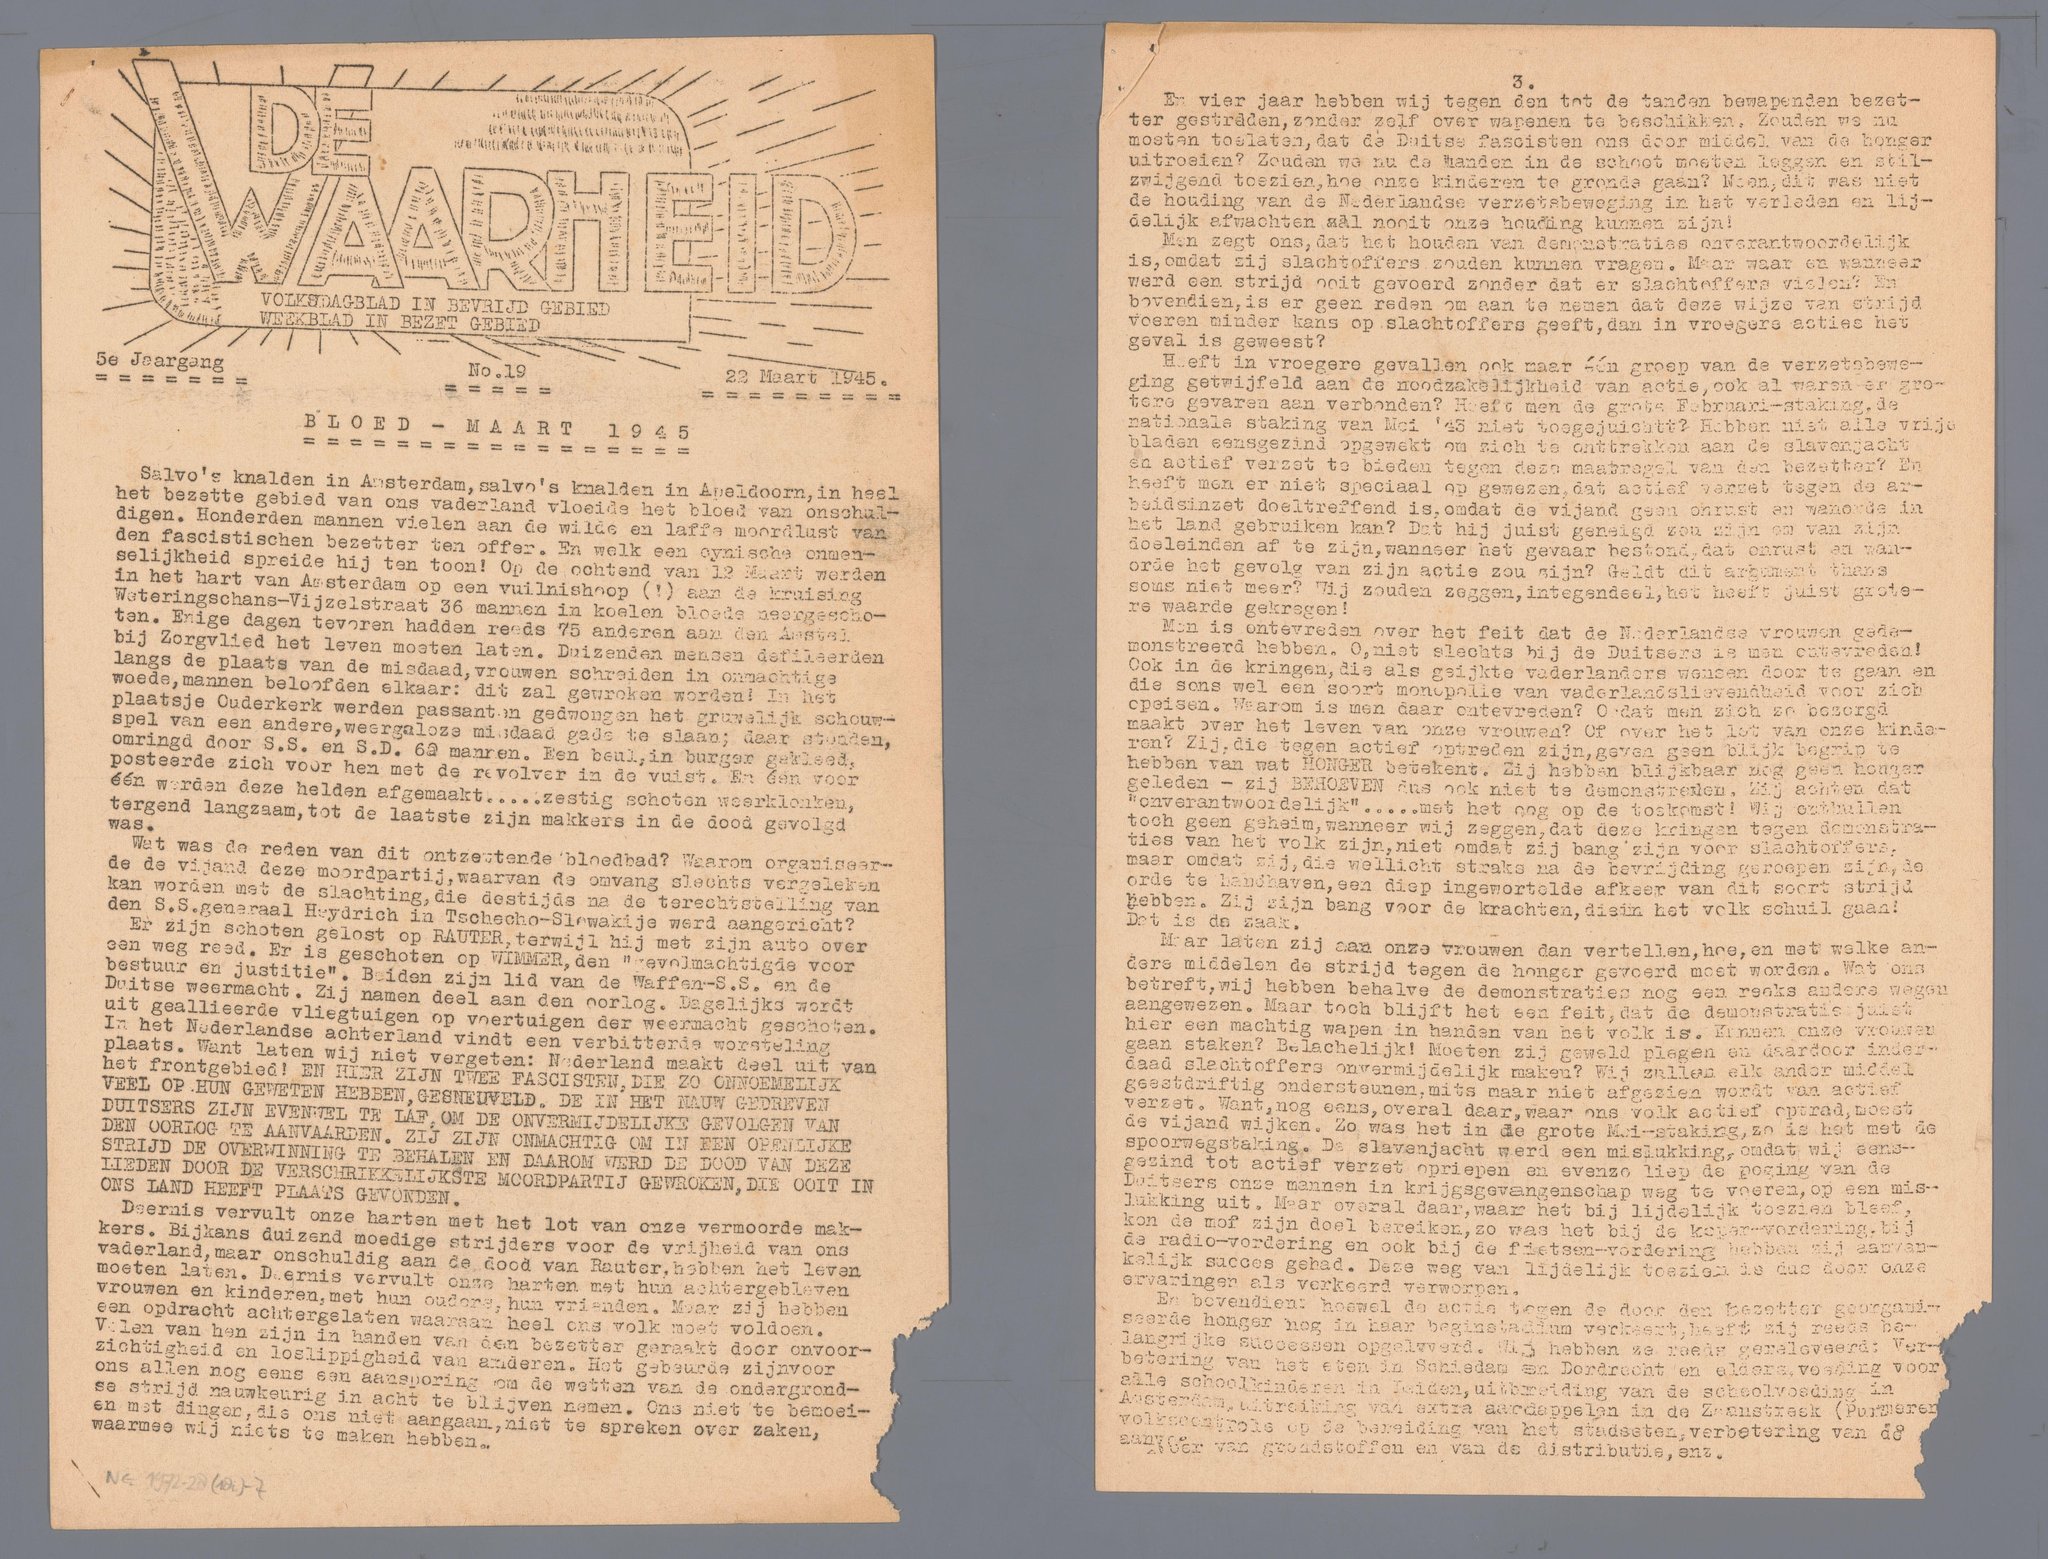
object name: newspaper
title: De Waarheid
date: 1945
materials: paper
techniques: mimeography, printing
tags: netherlands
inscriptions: date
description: Nummer van het illegale blad 'De Waarheid': No 19 'Bloed Maart 1945', 4 pp. Opschrift; l.b.: 'Volksdagblad voor bevrijd Nederlandd', r.b. 'Uitgave voor het bezette gebied'. Gedateerd: boven.